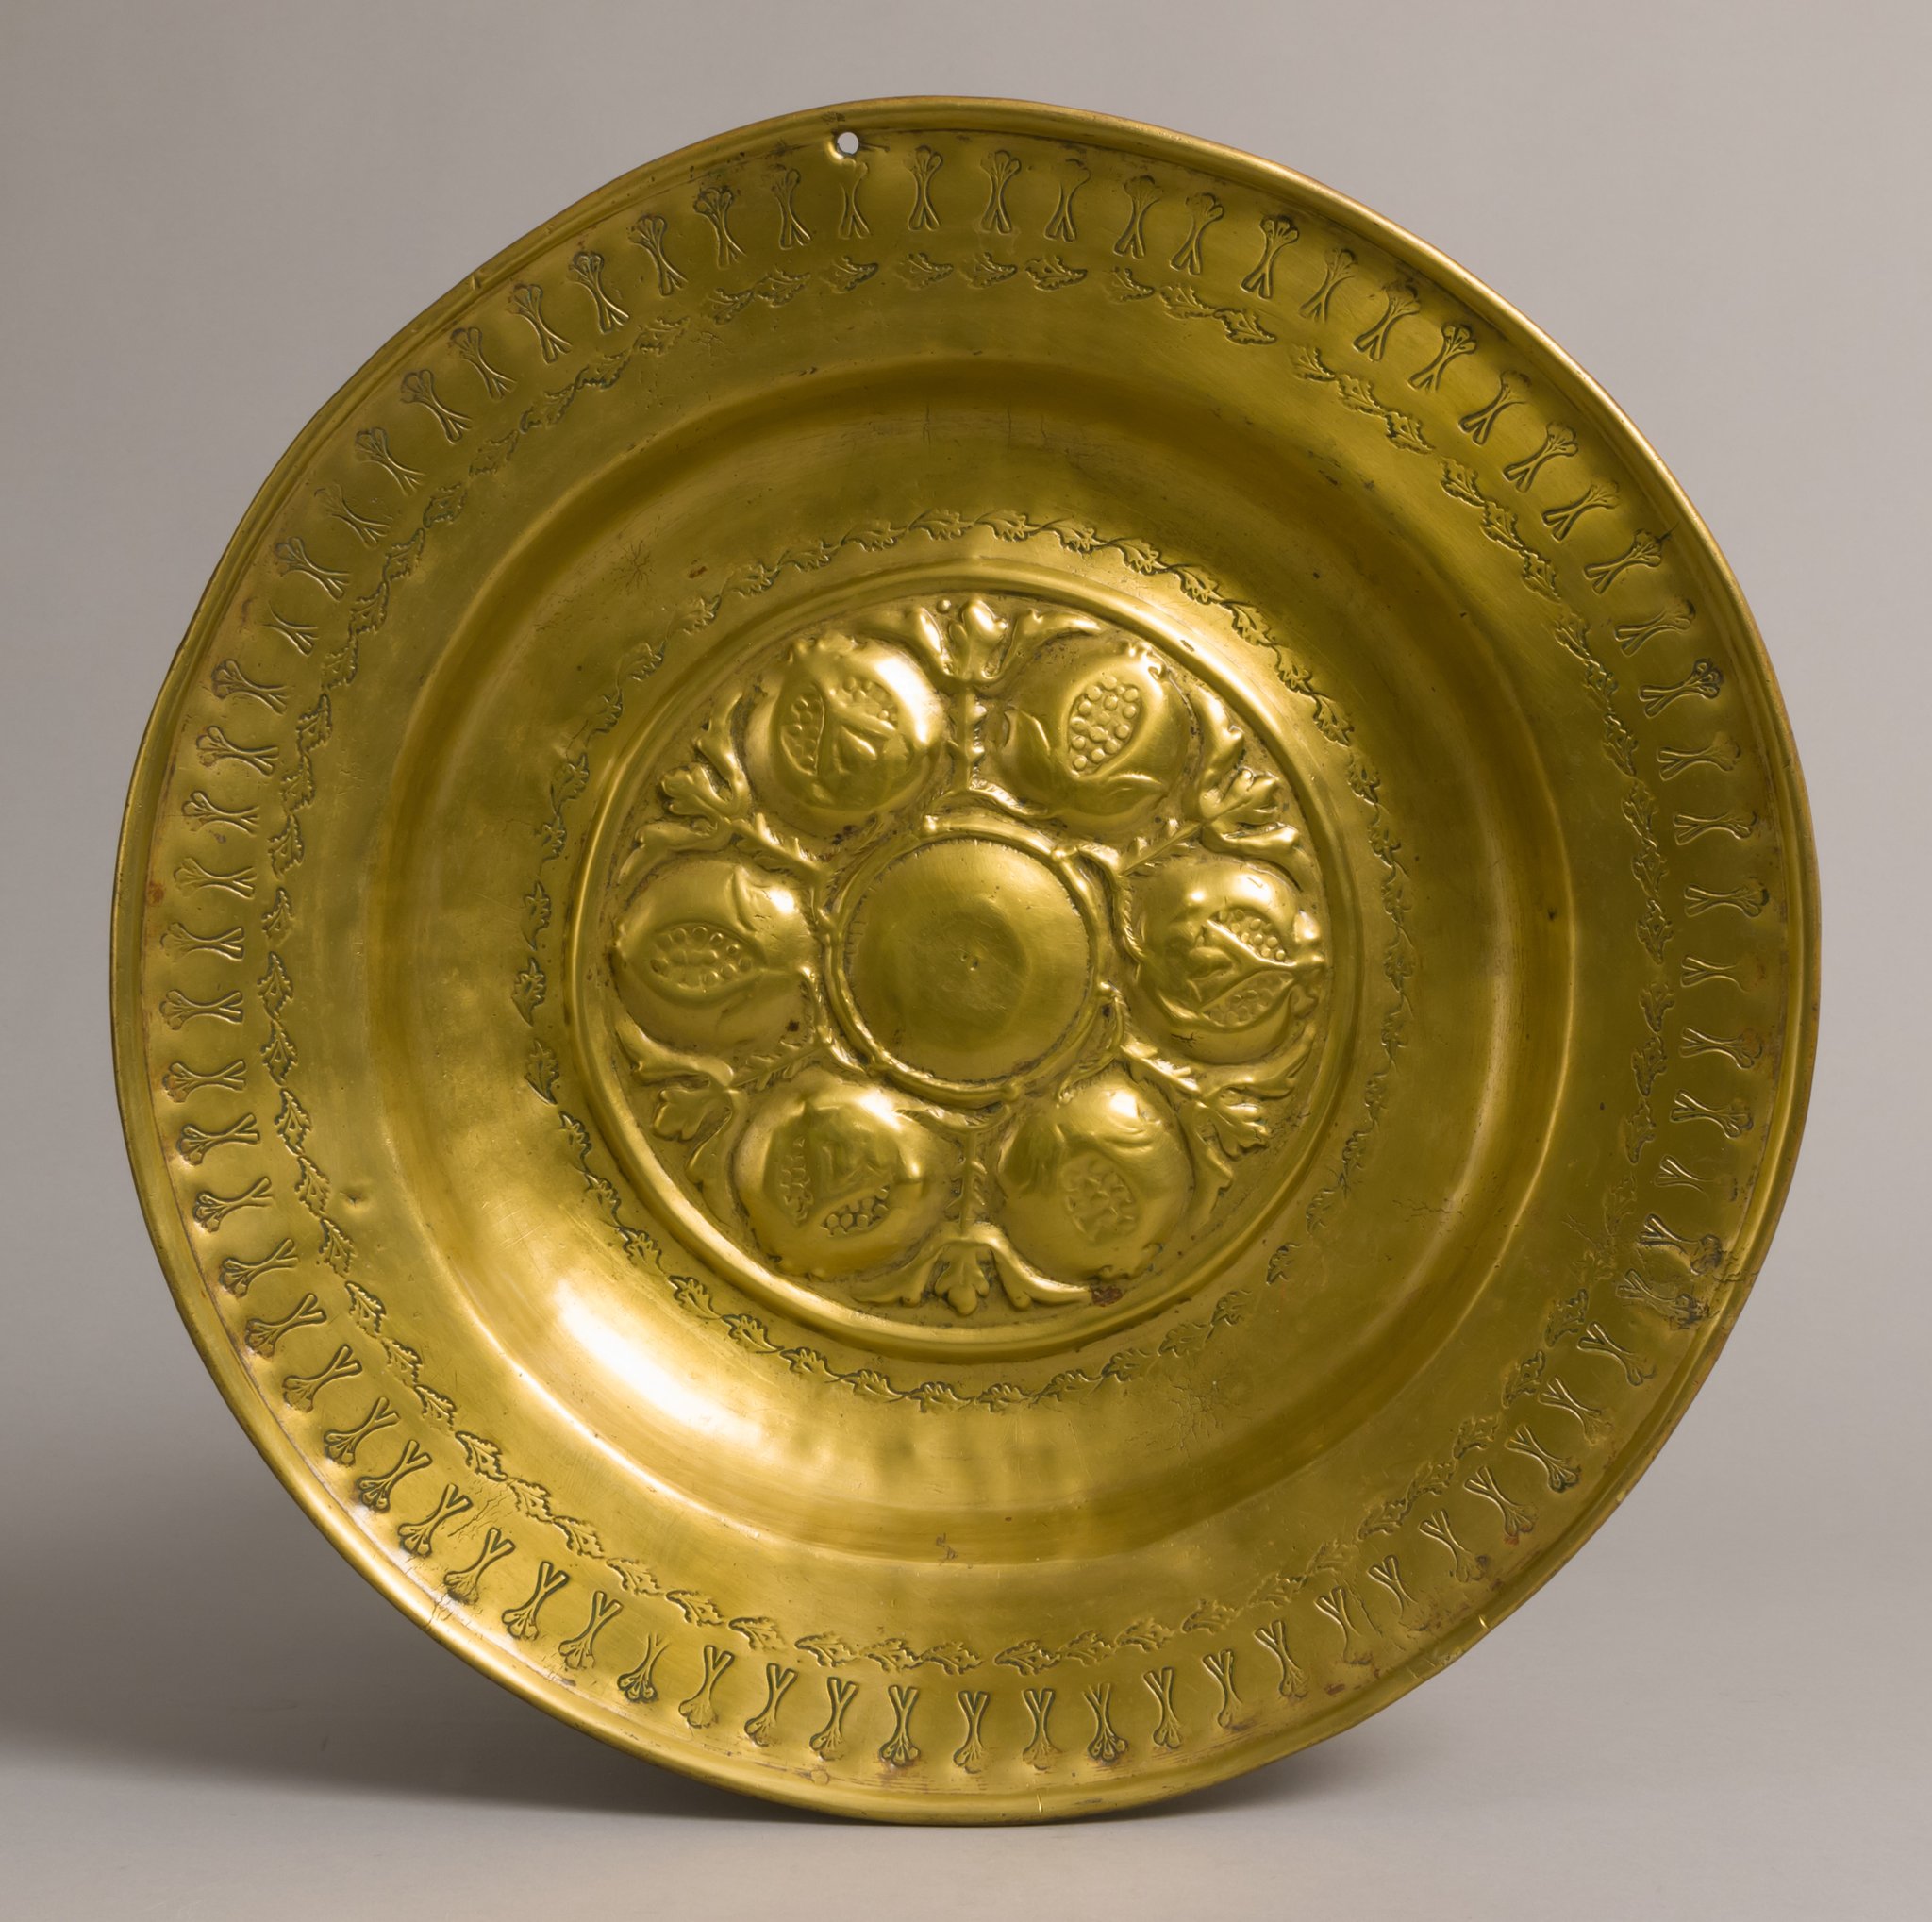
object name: dish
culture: german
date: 1501-1533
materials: brass